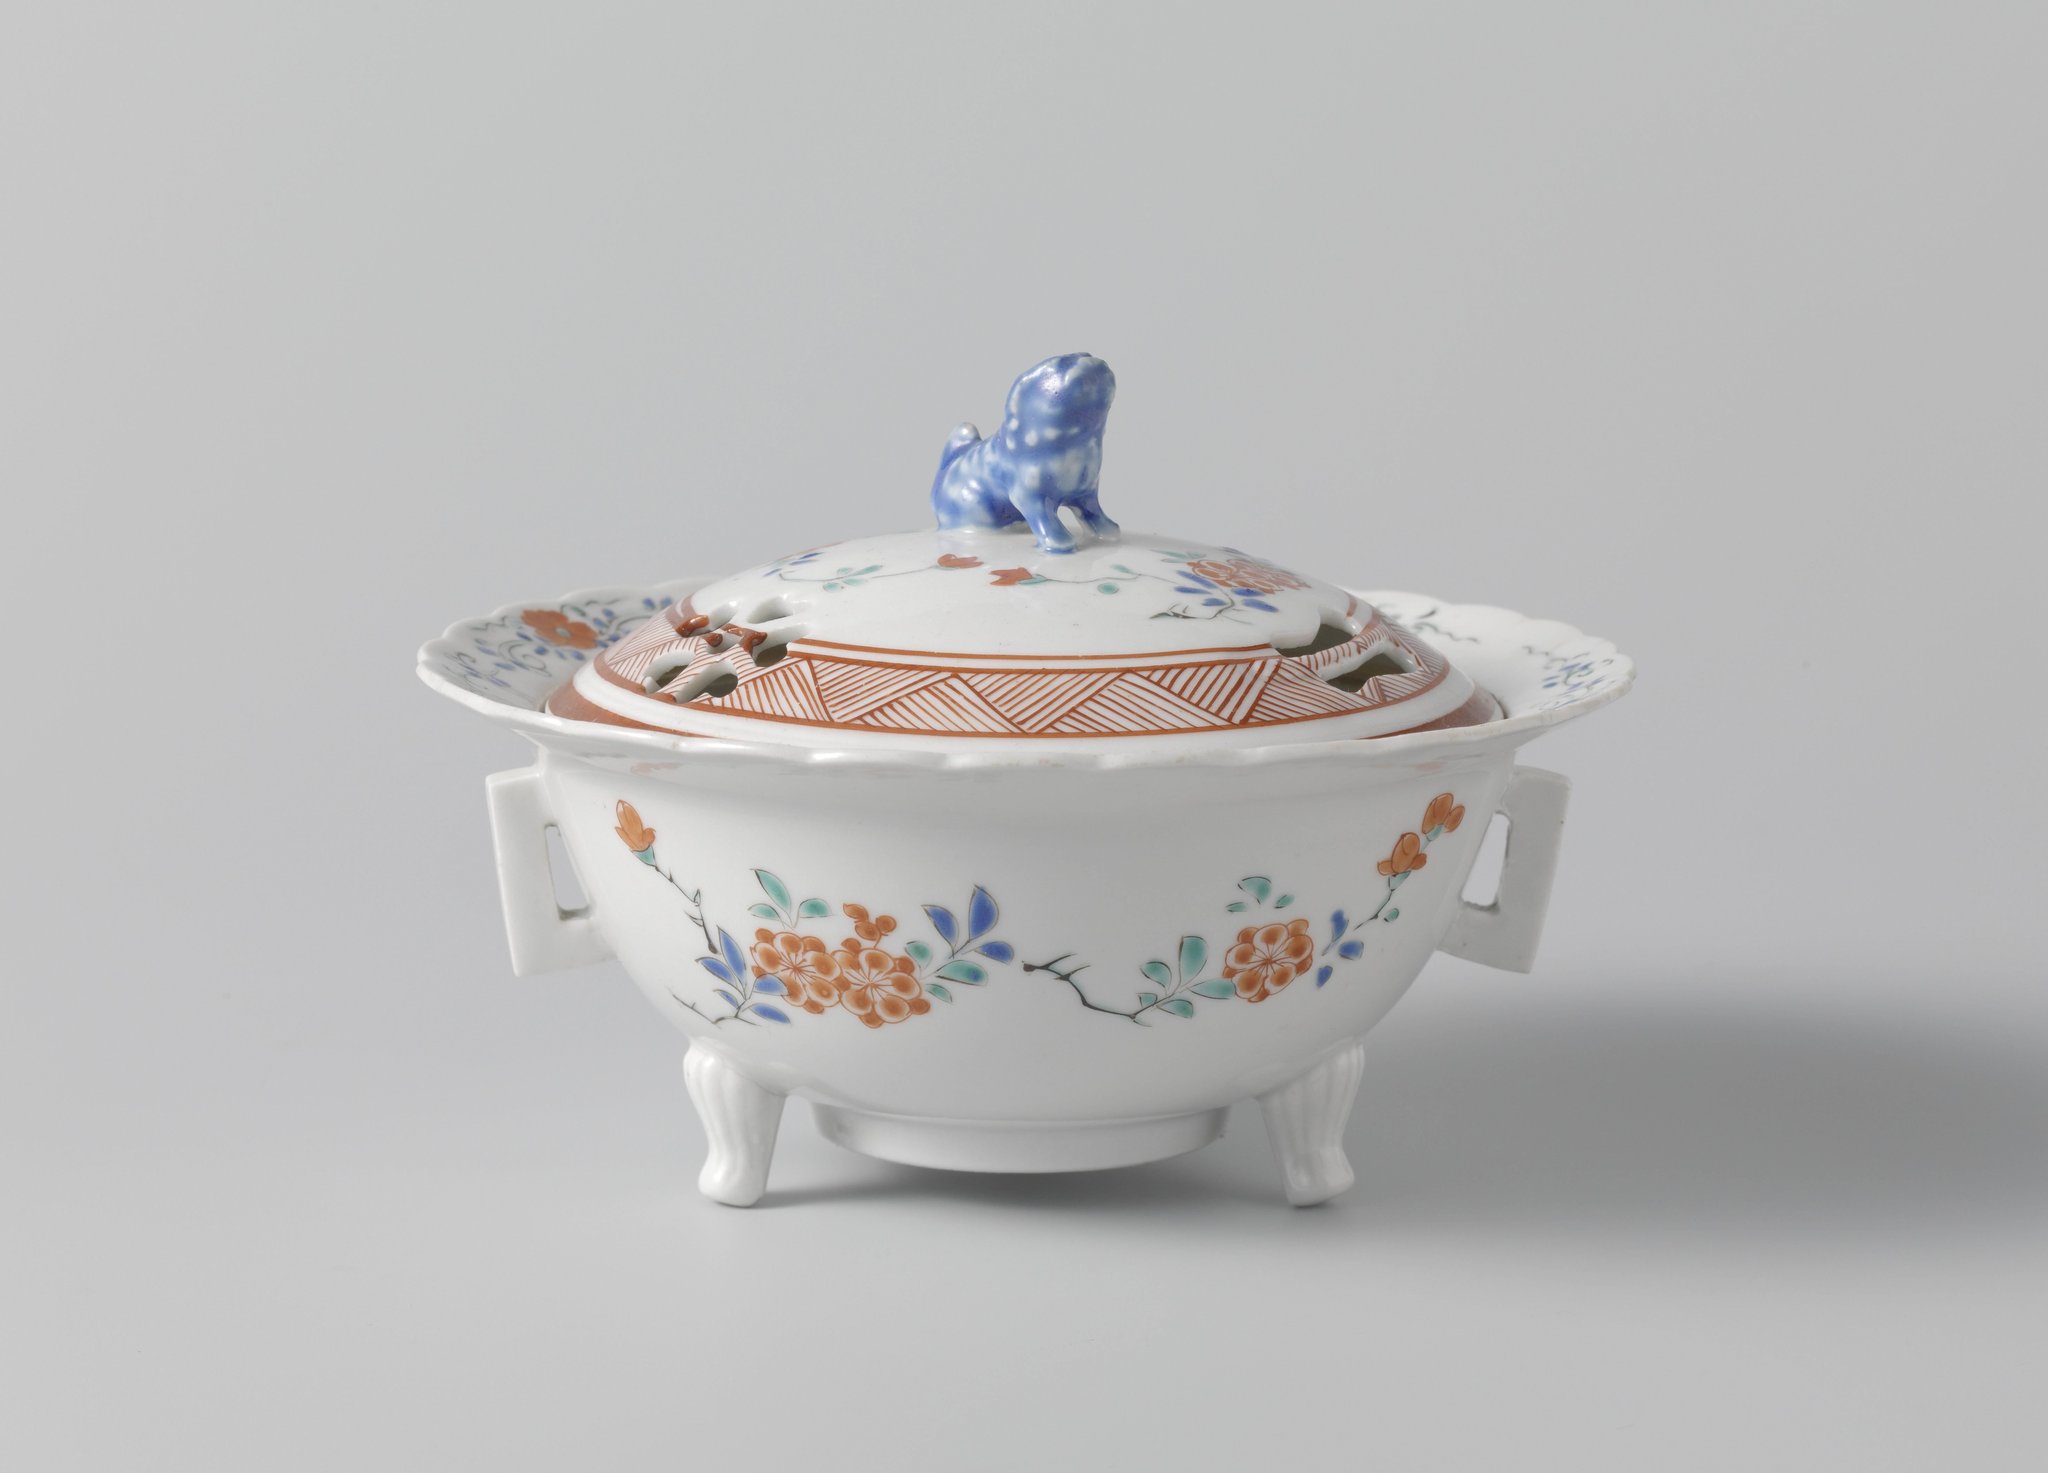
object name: incense burner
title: Incense burner with a cover and flower sprays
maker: Anonymous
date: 1670-1690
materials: glaze, paint, porcelain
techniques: firing, turning, vitrification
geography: arita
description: Incense burner, c. 1690 - 1710.